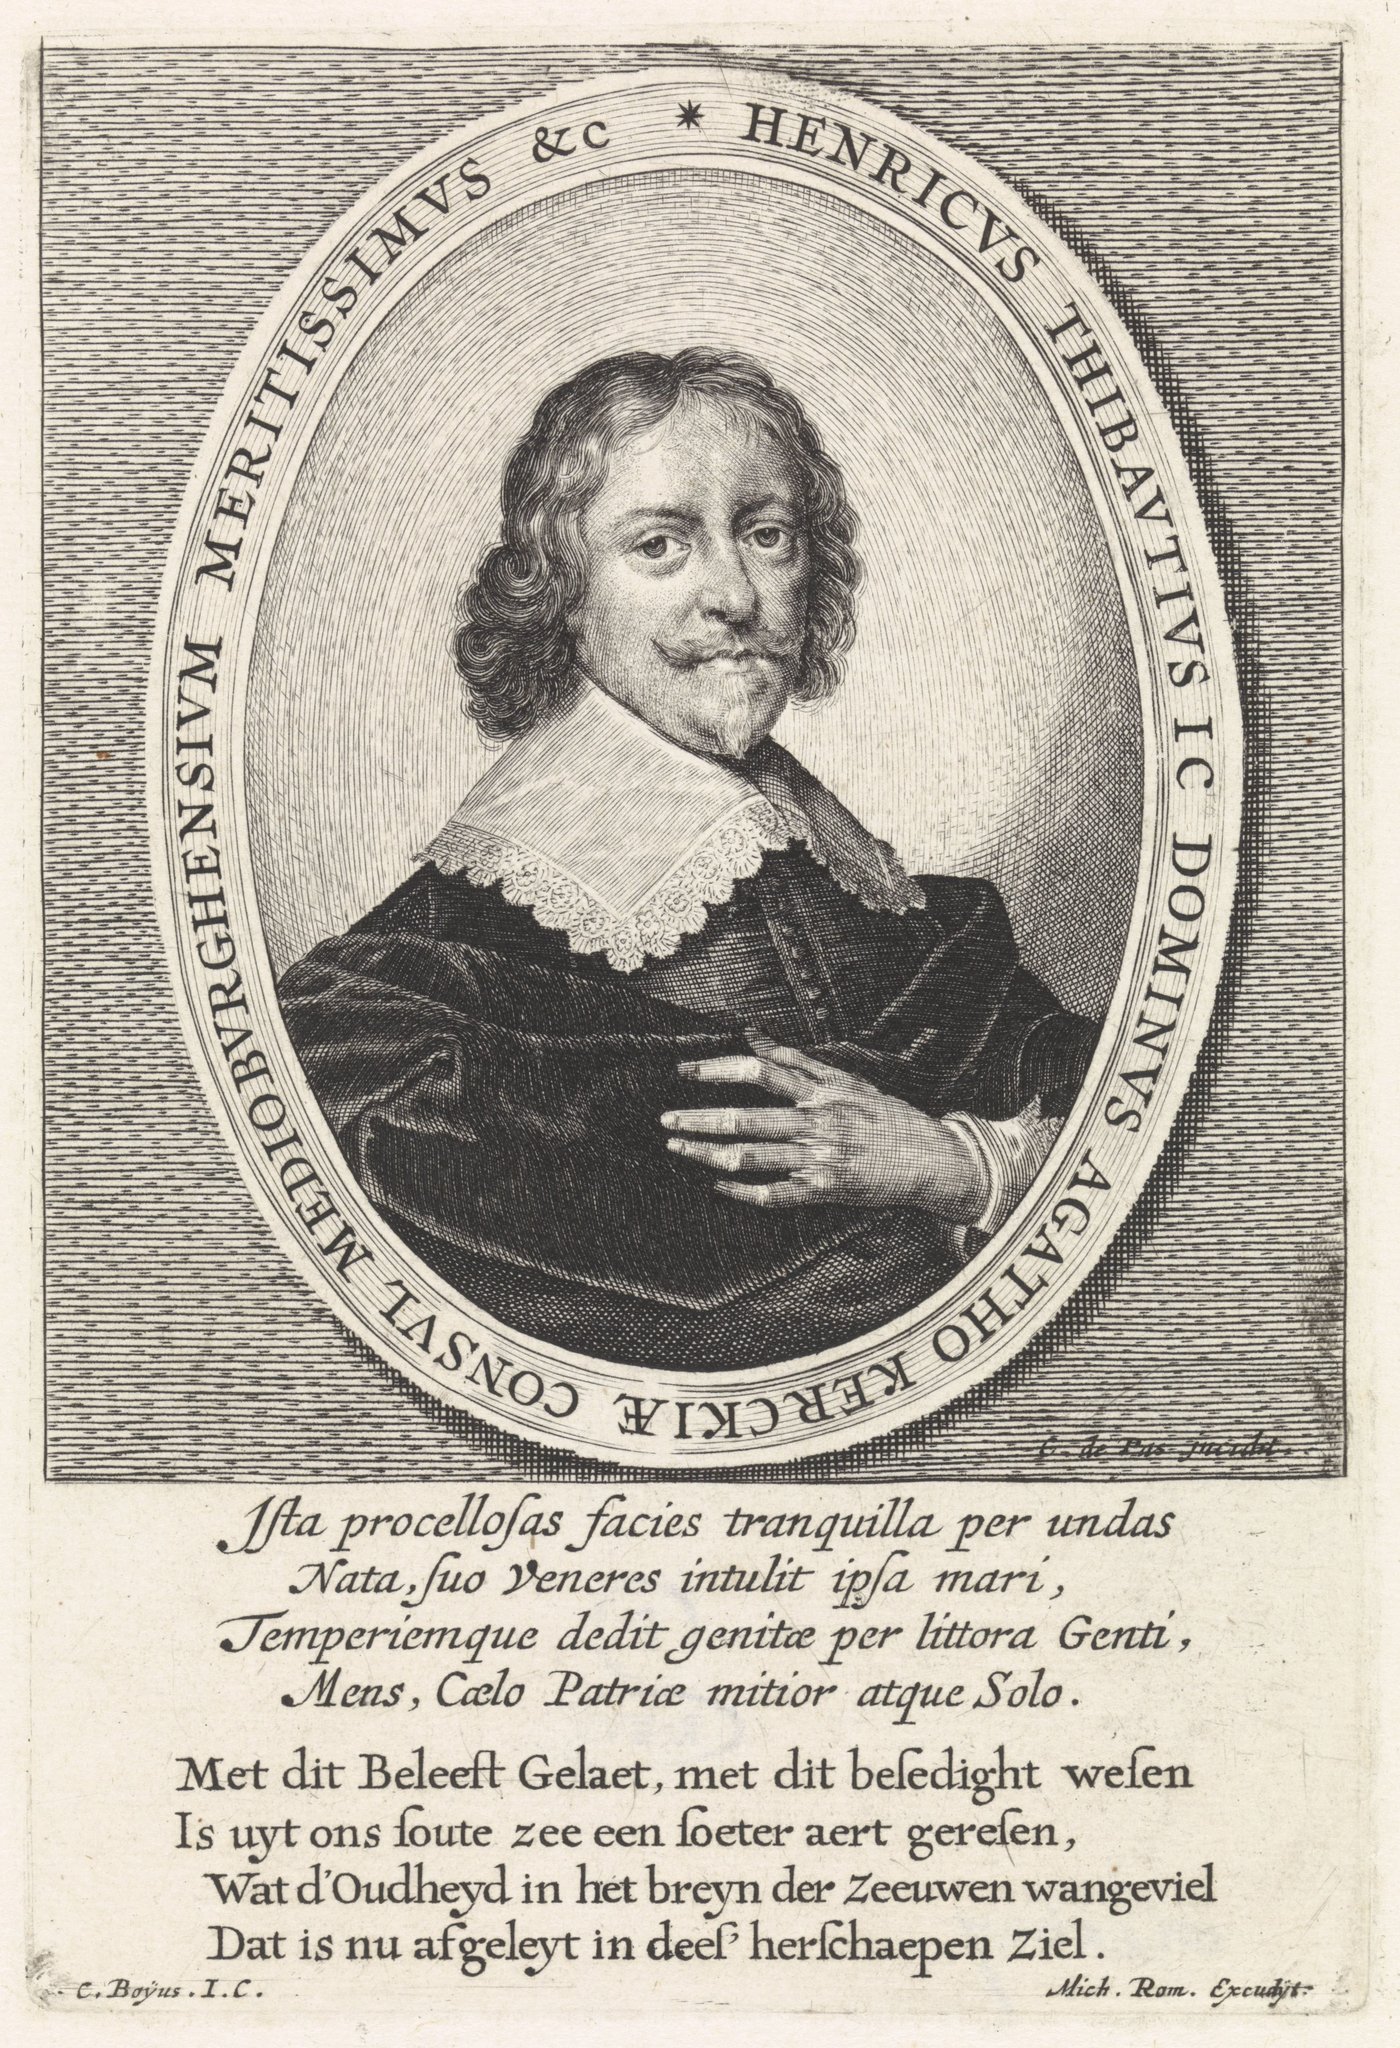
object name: print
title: Portret van Hendrick Thibaut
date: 1667-1670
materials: paper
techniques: engraving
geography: amsterdam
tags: middelburg, mayor, hendrick thibaut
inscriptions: collector's mark: Lugt 964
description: Portret van Hendrick Thibaut, Zeeuws politicus en burgemeester te Middelburg. In de marge een vierregelig lofdicht in het Latijn en in het Nederlands.